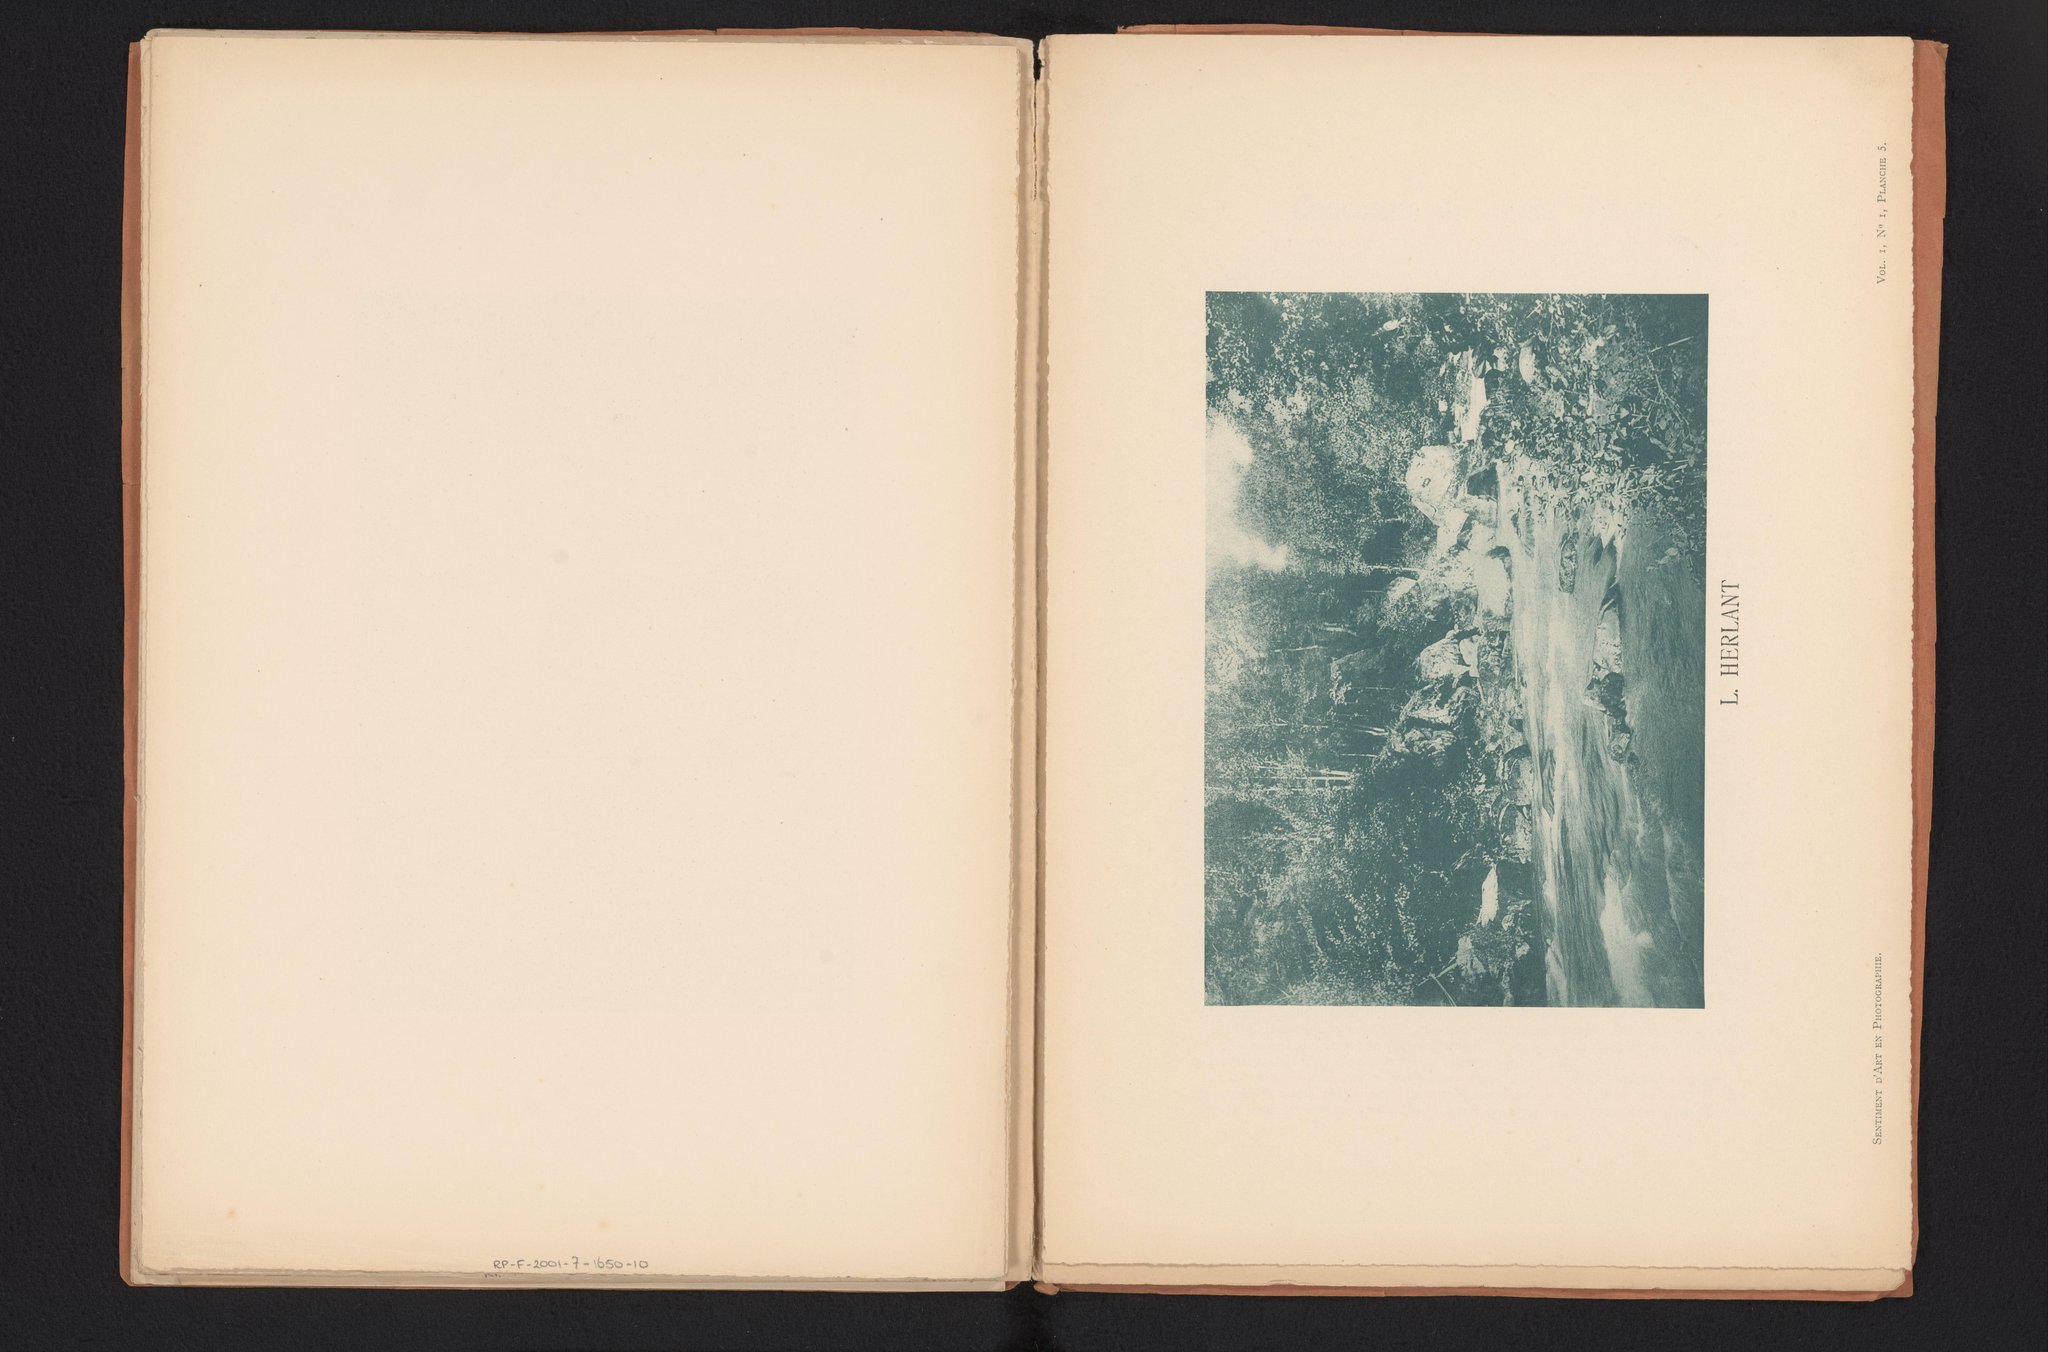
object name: photomechanical print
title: Sentiment d'Art en Photographie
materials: paper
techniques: photograph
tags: rapids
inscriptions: number: ‘Vol. 1, No 1, Planche 5.’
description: Deze prent maakt deel uit van 8 omslagen met 22 tekstbladen en 89 prenten op losse bladen in en tussen de omslagen.